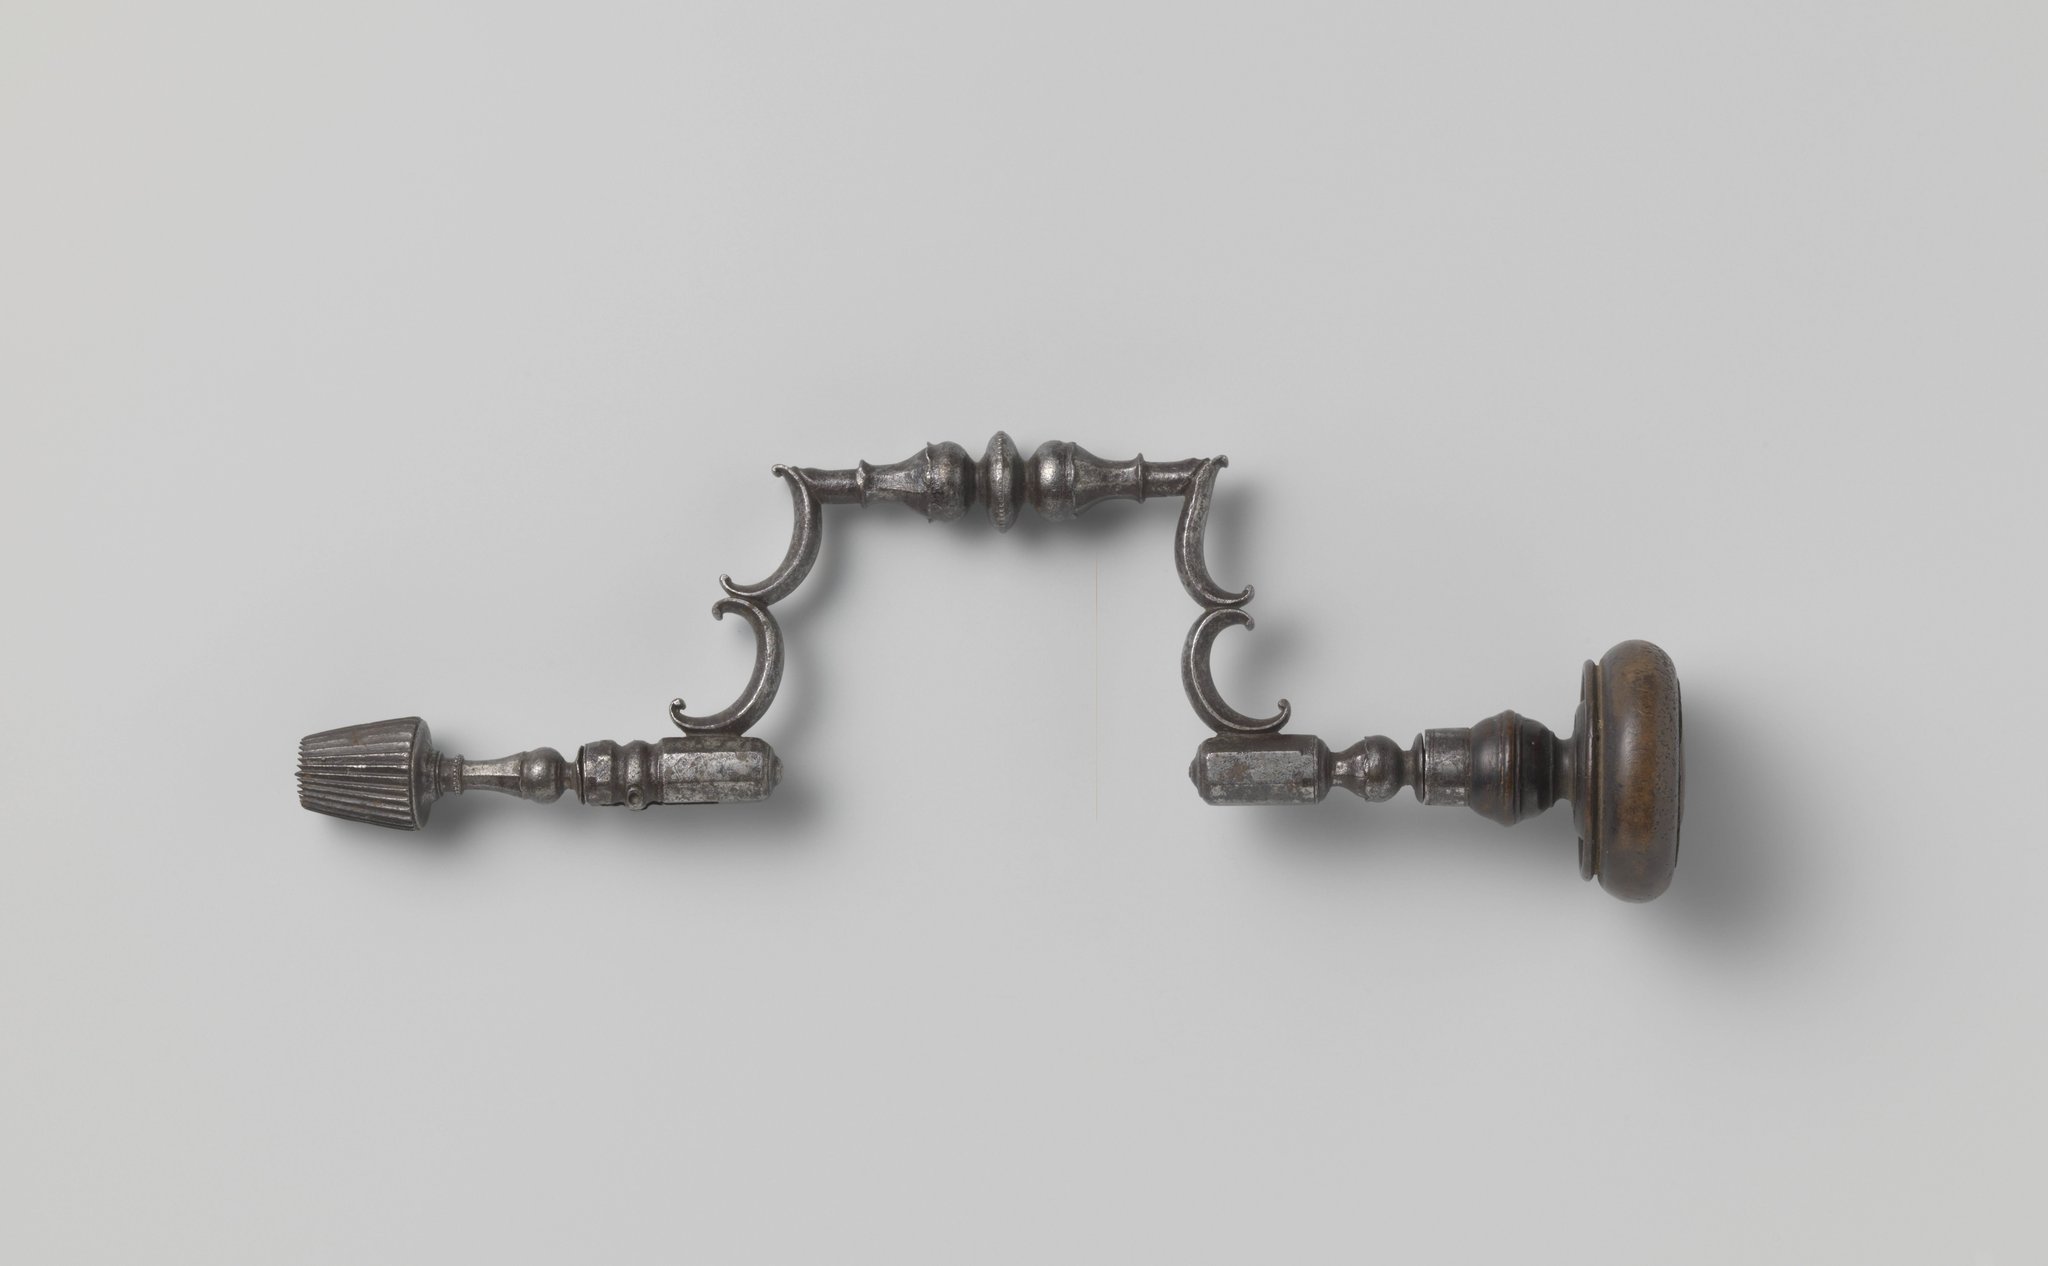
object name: drill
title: Boor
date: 1600-1625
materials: iron, wood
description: Een rijk versierde ijzeren boor met geprofileerde houten knop.